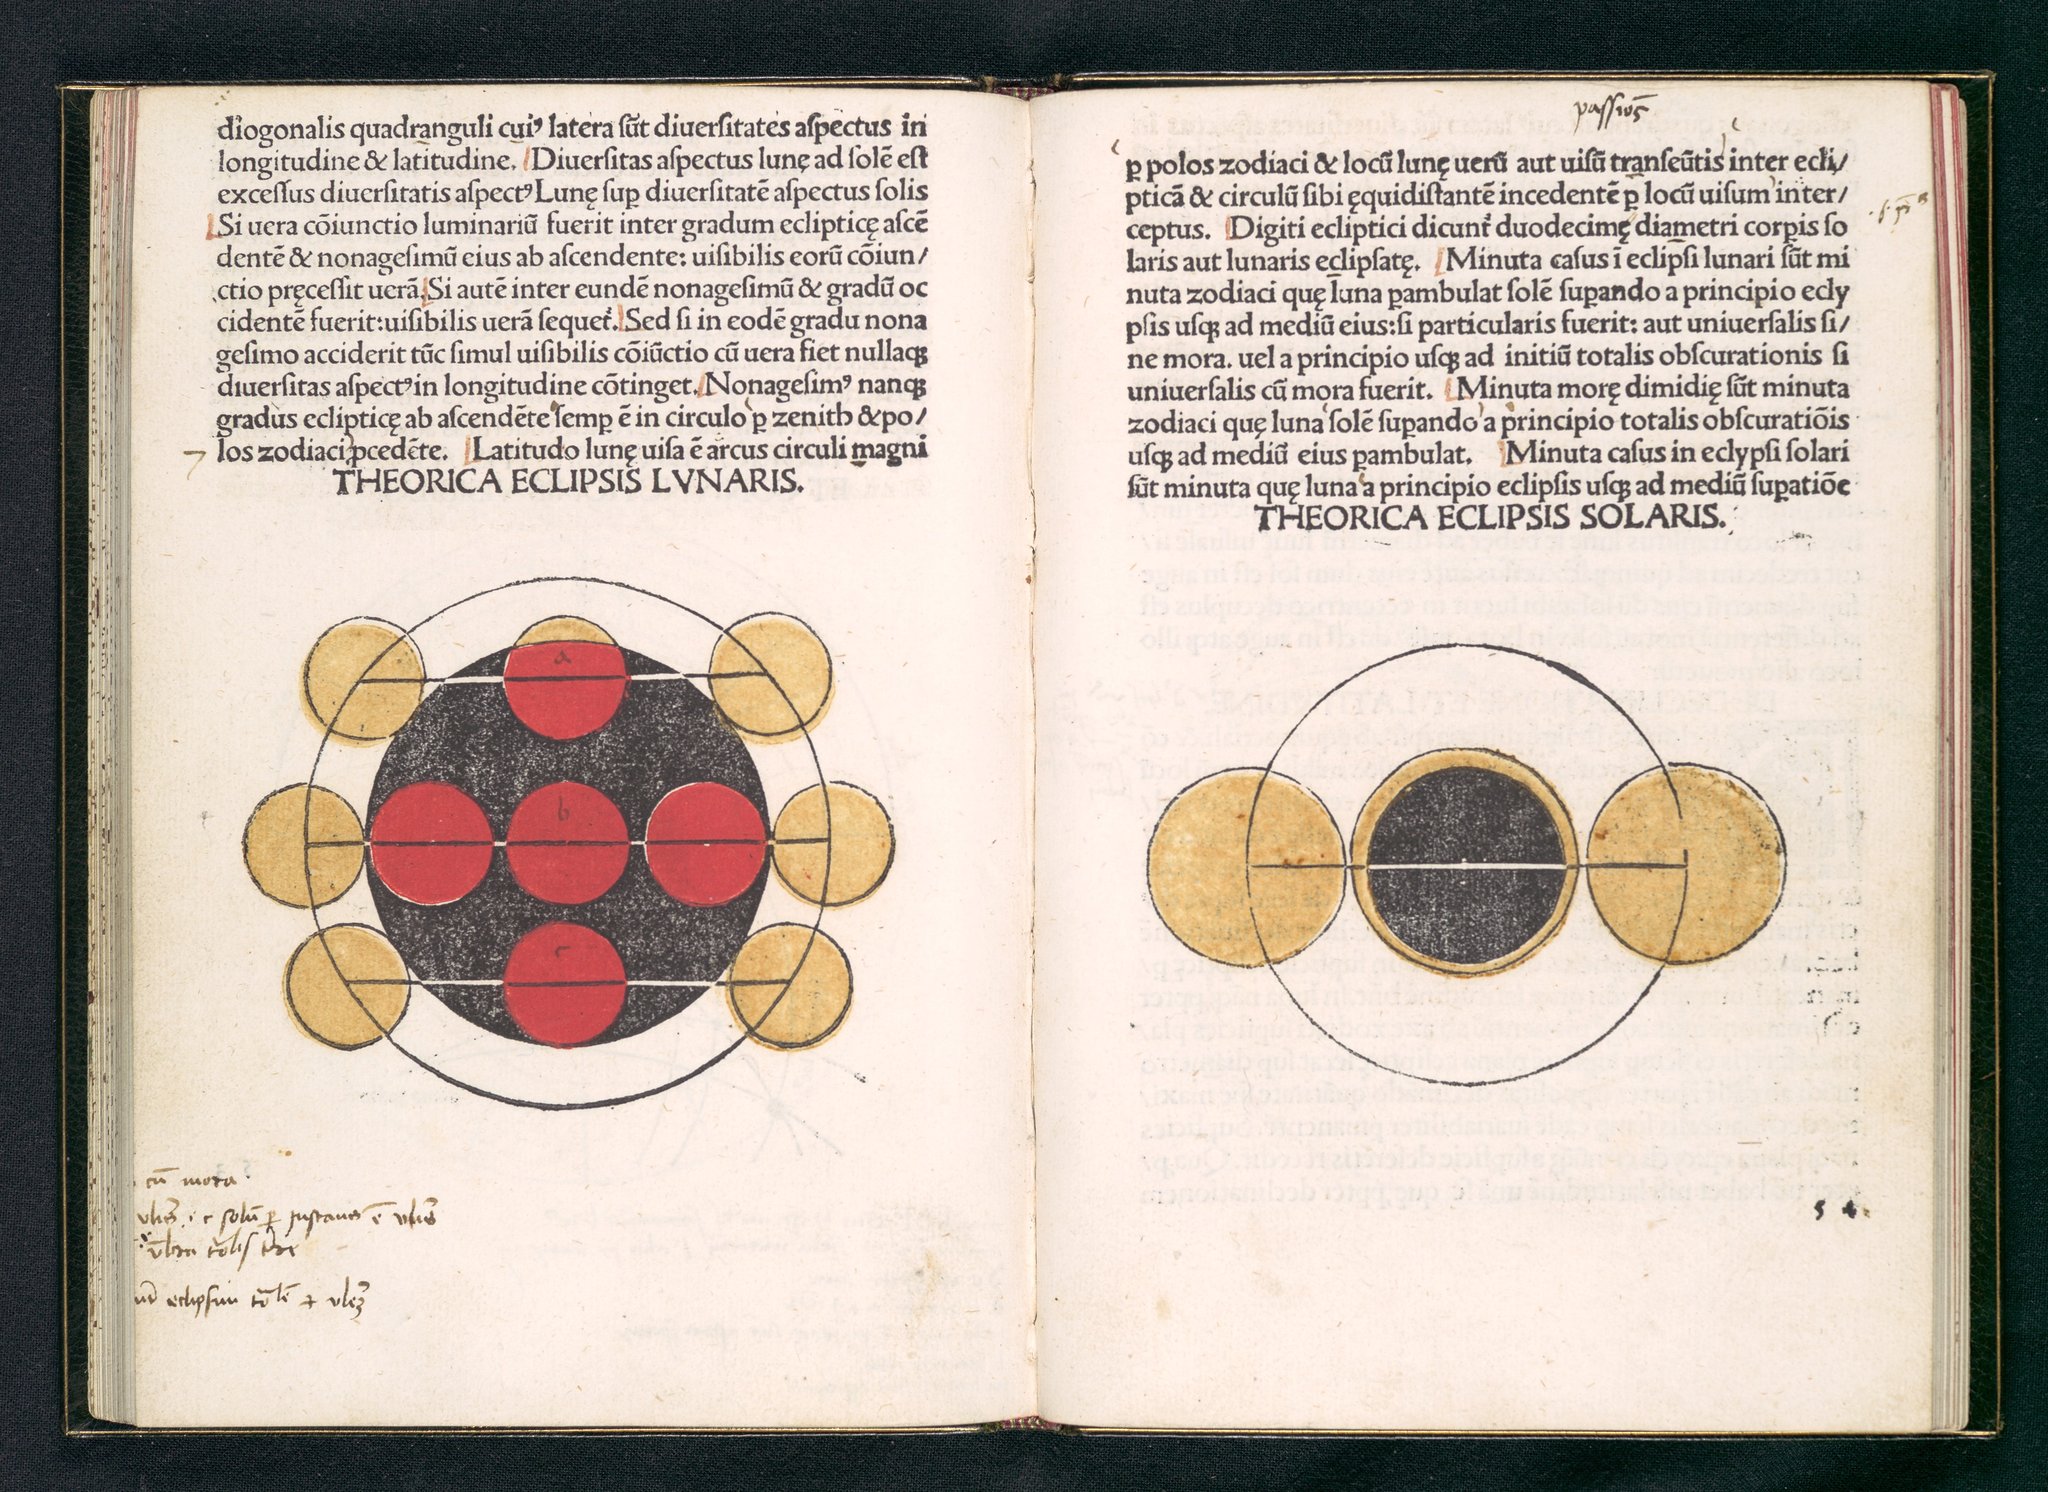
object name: book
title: Sphaera Mundi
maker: johannes de sacrobosco (john holybush)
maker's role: author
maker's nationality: scottish or british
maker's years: 1195-1256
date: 1485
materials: ink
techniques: printing, woodcut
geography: italy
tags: astronomy